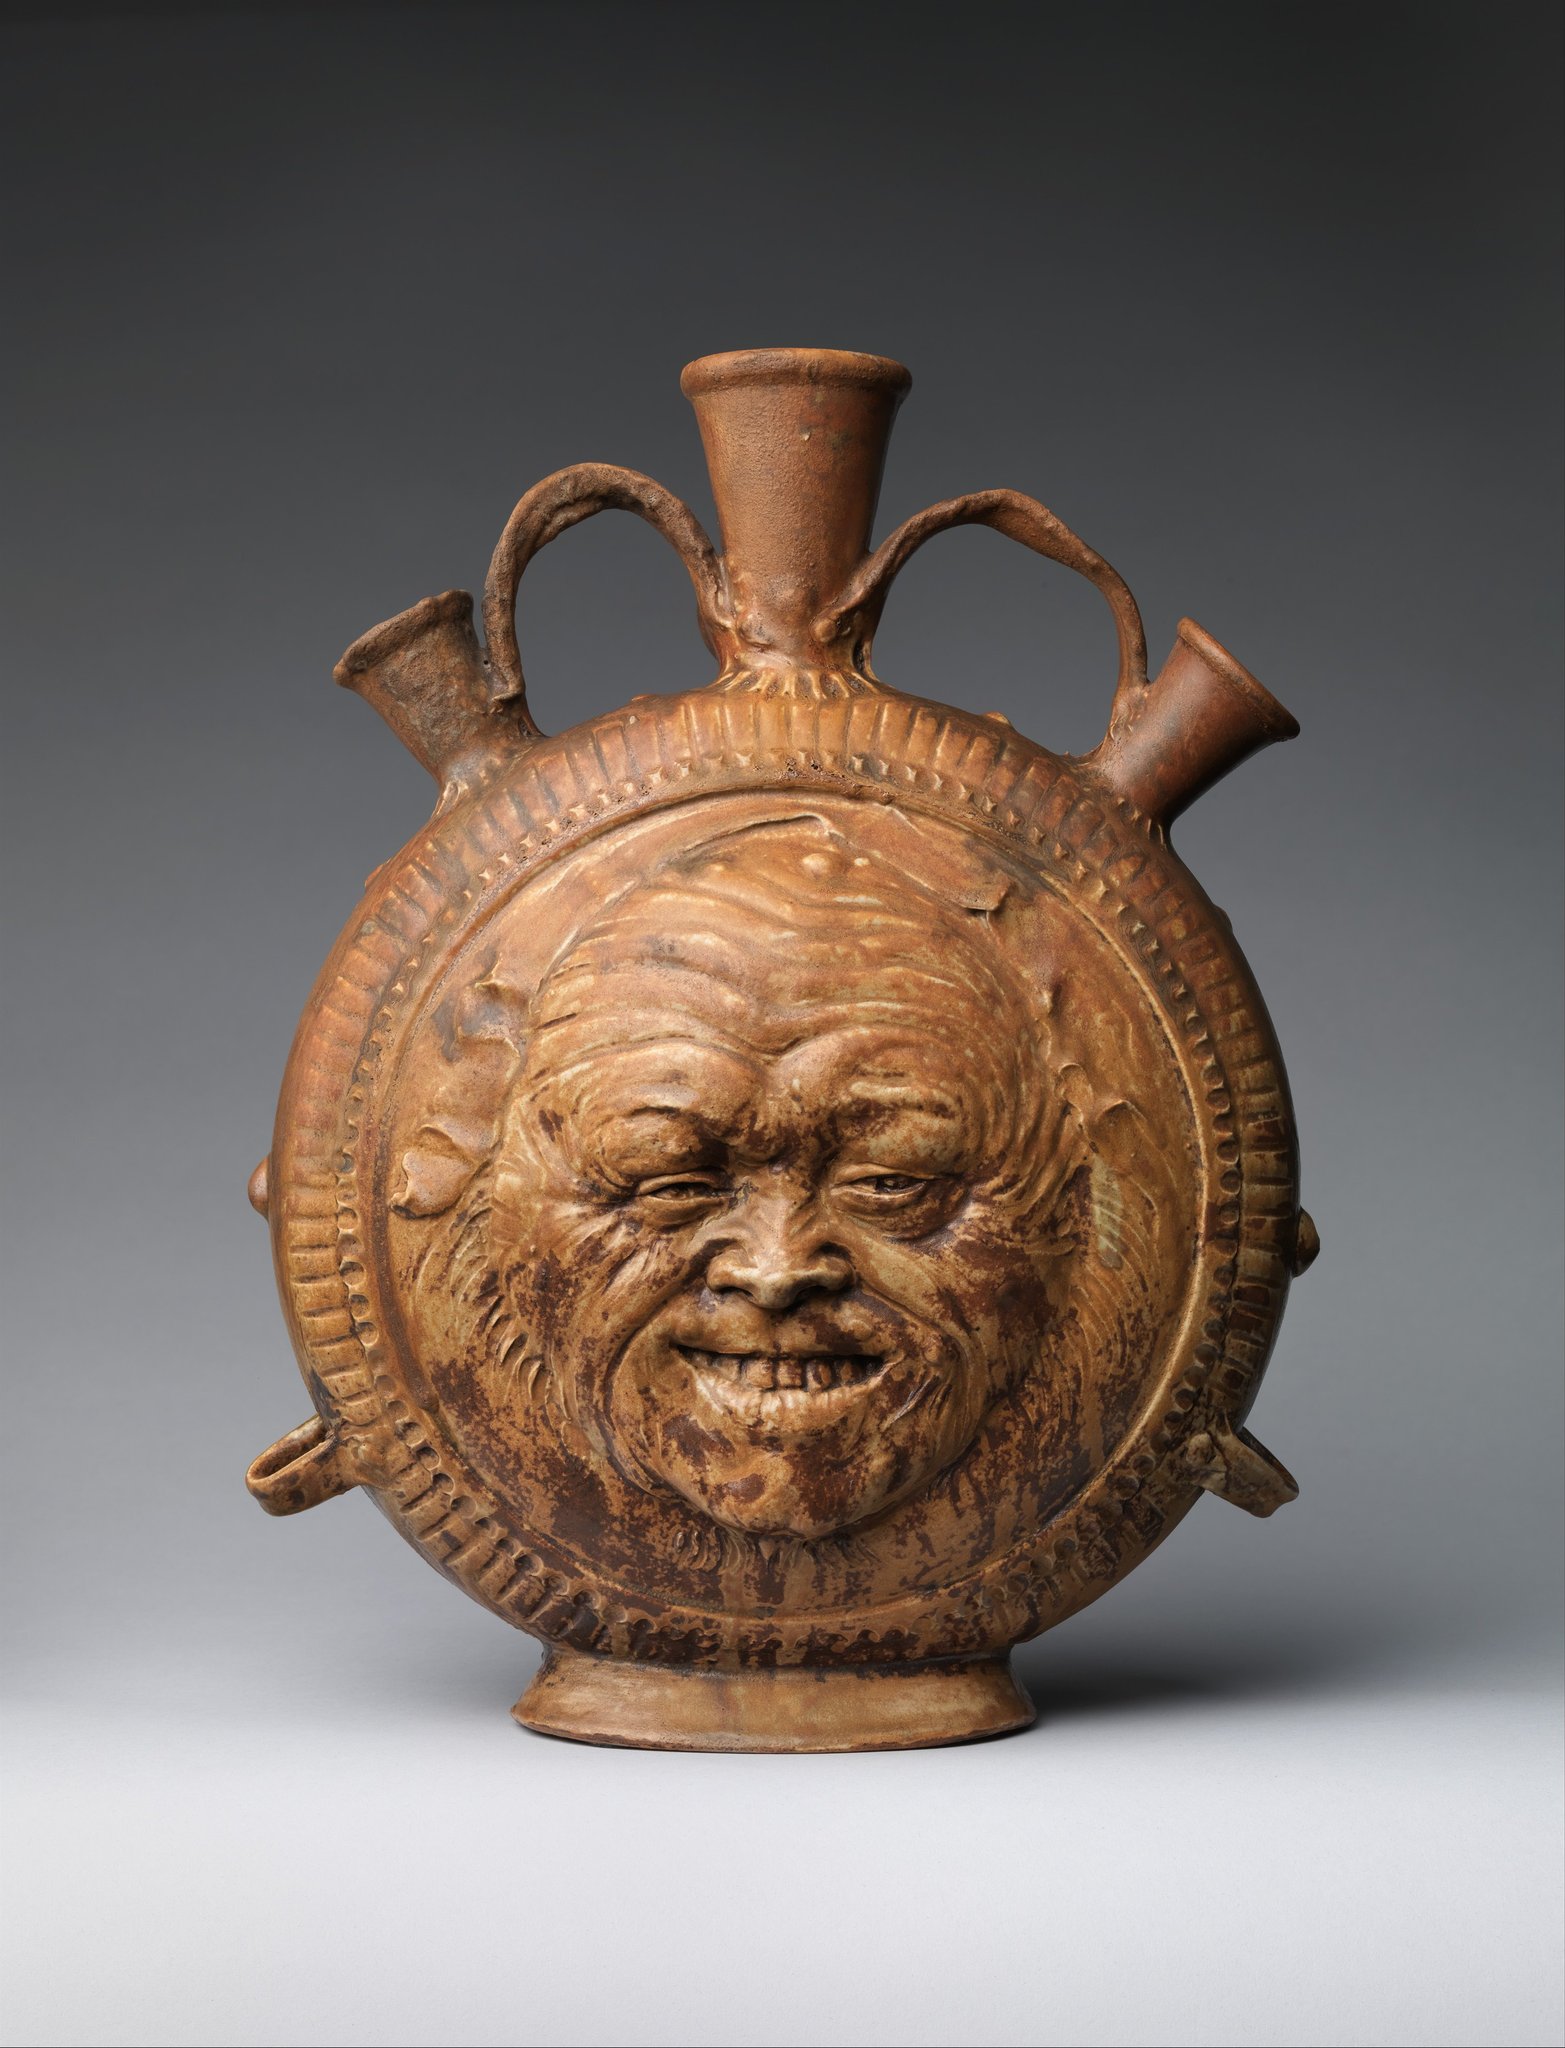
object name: flask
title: Flask with face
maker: jean-joseph carriès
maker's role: maker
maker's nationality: french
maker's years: 1855-1894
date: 1890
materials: stoneware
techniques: glazing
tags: faces